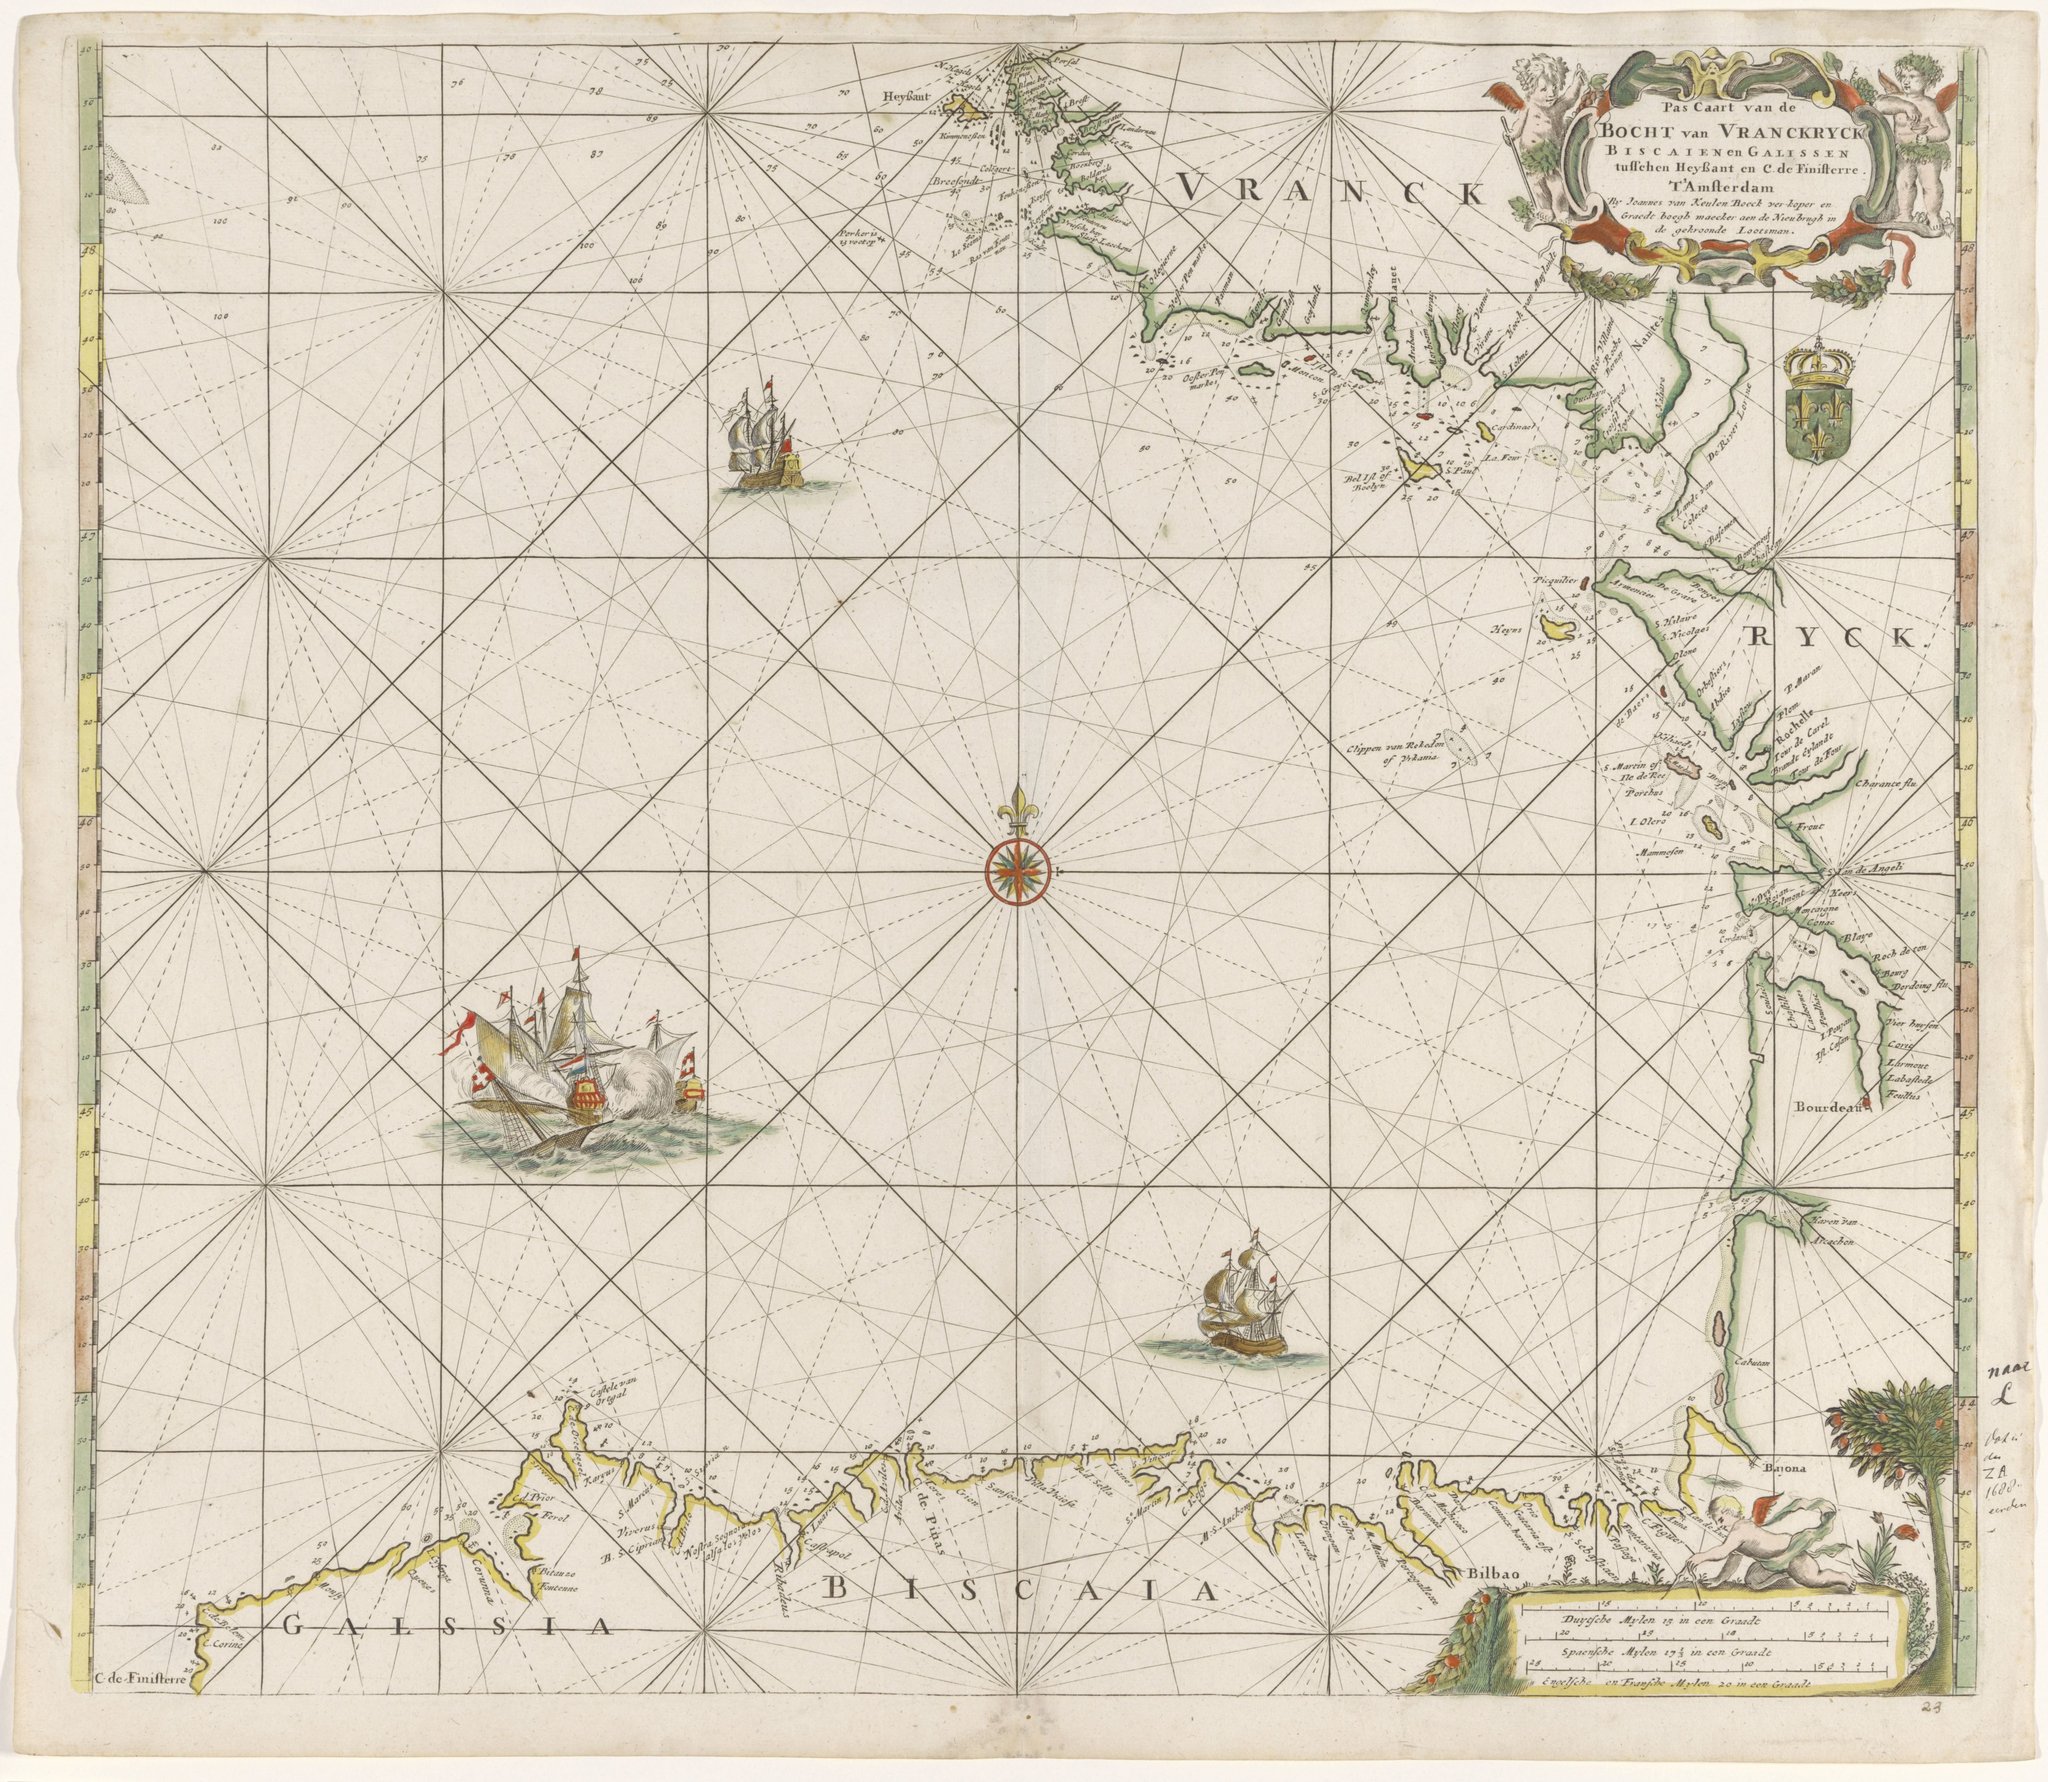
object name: print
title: Paskaart van een gedeelte van de kust van Frankrijk en Spanje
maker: johannes van keulen (i)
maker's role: bookseller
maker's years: 1653-1715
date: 1682-1734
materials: paper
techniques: brush, engraving, hand coloring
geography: amsterdam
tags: maps, atlases, cupids: 'amores', 'amoretti', 'putti', france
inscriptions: collector's mark: Lugt 2228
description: Paskaart van een deel van de kust van Frankrijk en Spanje, met de Golf van Biskaje. In het centrum een kompasroos, het Noorden ligt boven. Rechtsboven een door twee engeltjes geflankeerde cartouche met de titel en het adres. Rechtsonder de schaal in Duitse, Spaanse en Engelse of Franse mijlen.